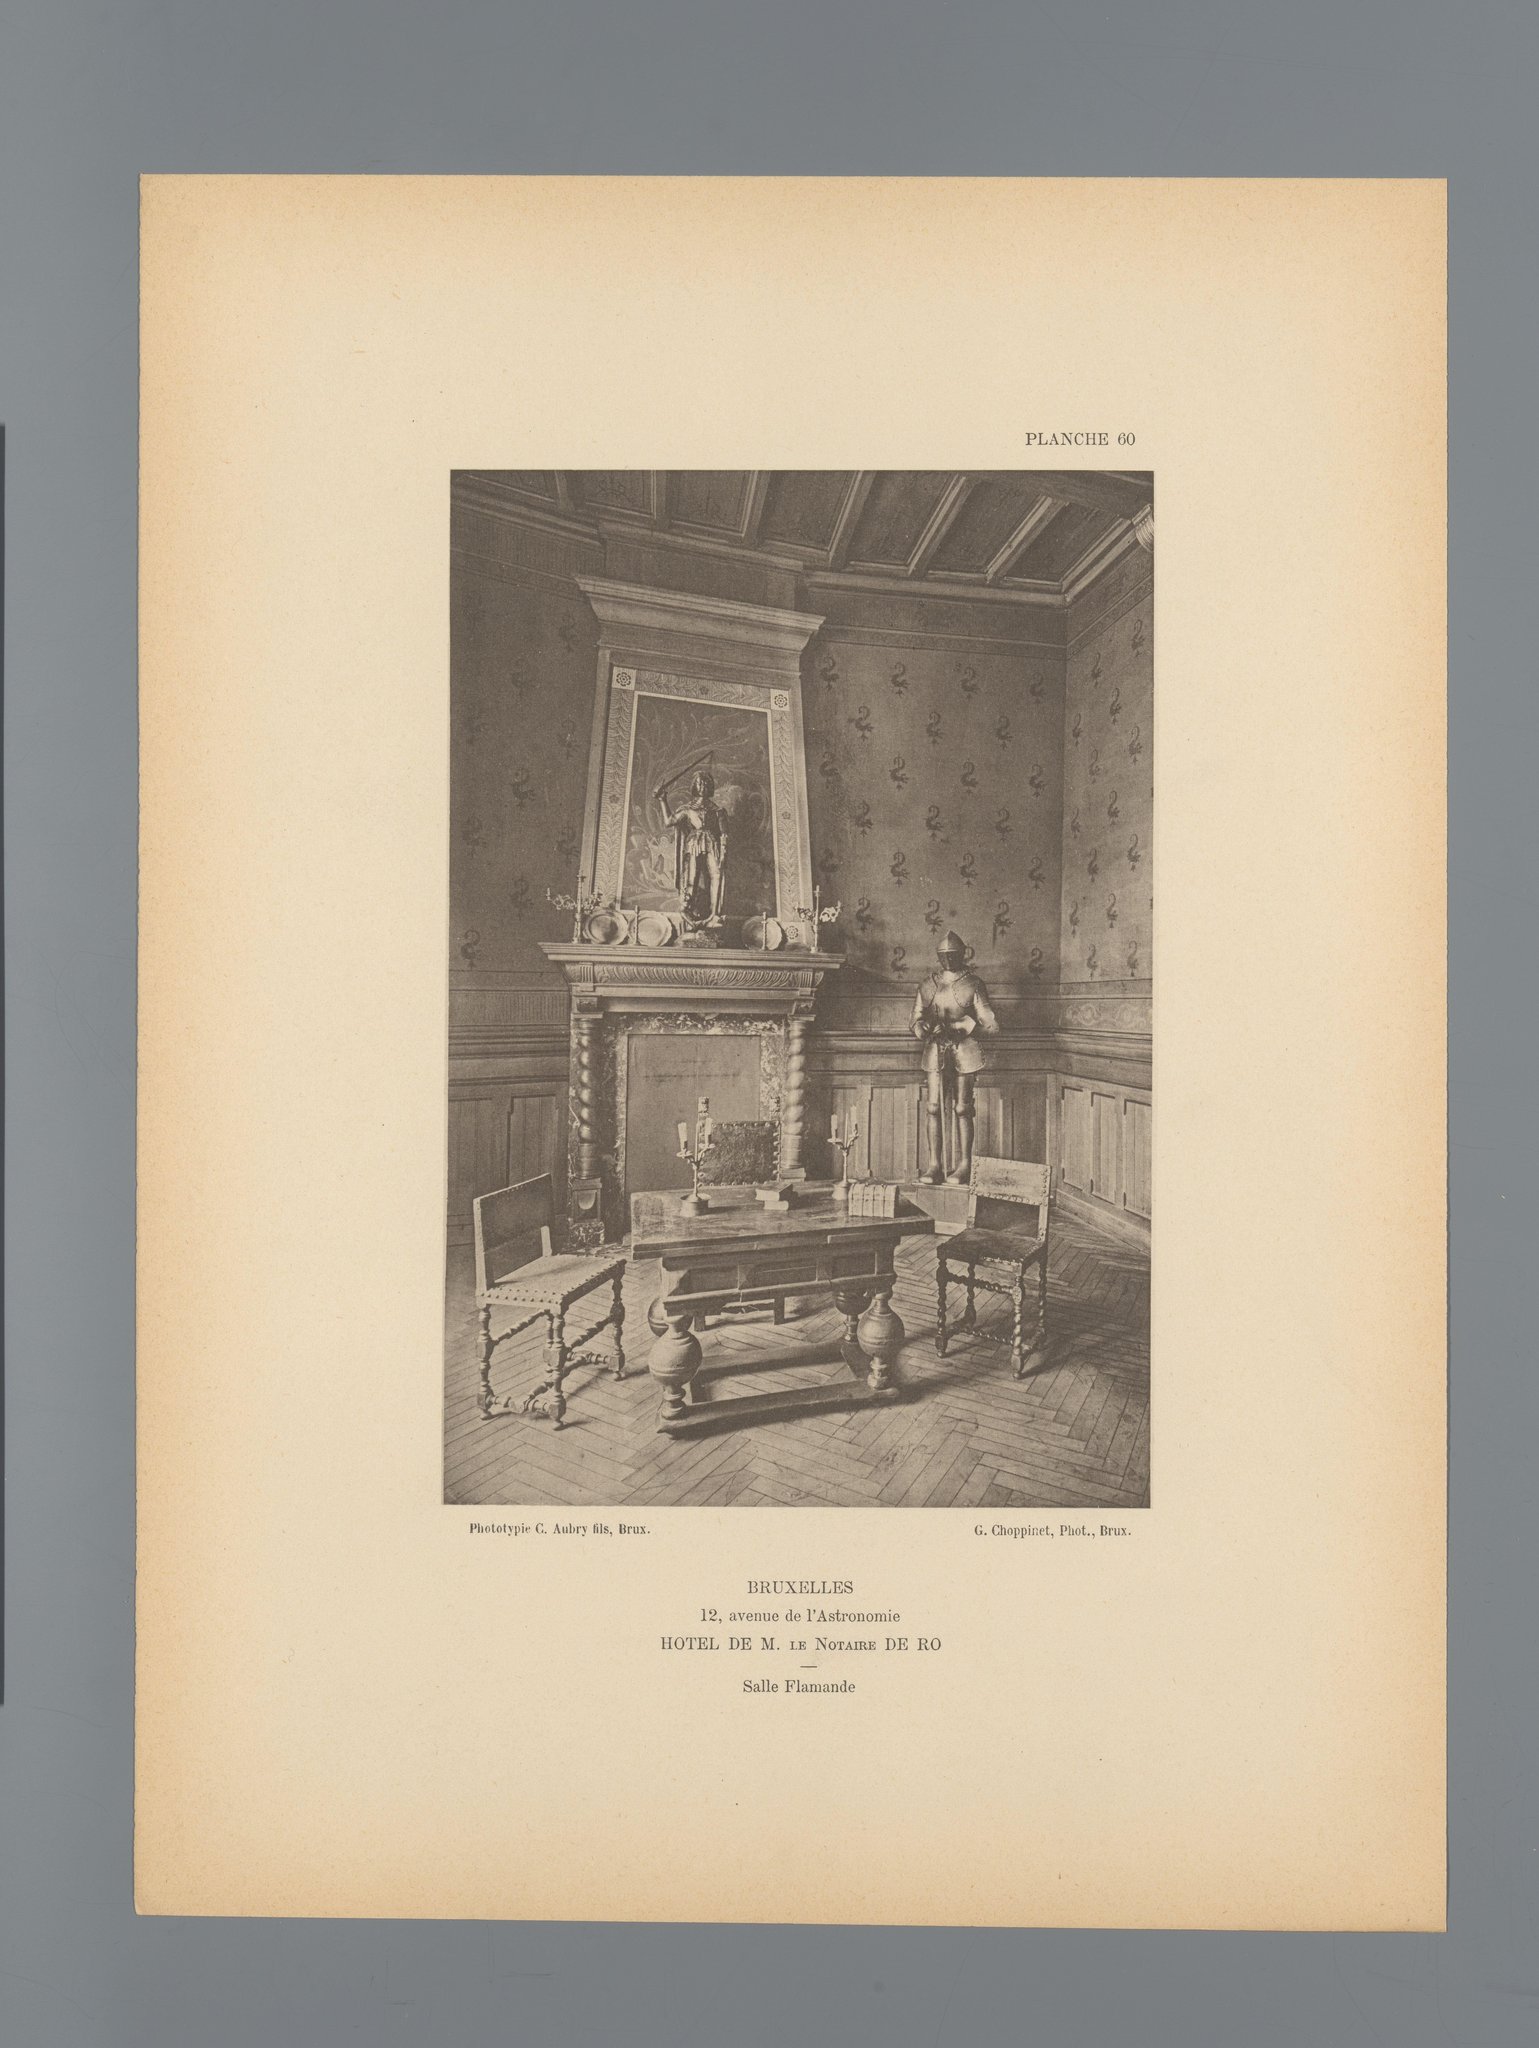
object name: photomechanical print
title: Gezicht op een zaal in Vlaamse stijl in het hotel van De Ro in Brussel, België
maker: gustave choppinet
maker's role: fotograaf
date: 1893-1898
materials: paper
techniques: photograph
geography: brussels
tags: interior of the house, hotel, hostelry, inn, brussels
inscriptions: inscription: ‘12, avenue de l'Astronomie/ HOTEL DE M. le Notaire DE RO/ Salle Flamande’, number: ‘PLANCHE 60’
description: Deze prent maakt deel uit van een omslag met 89 prenten en 5 tekstbladen.